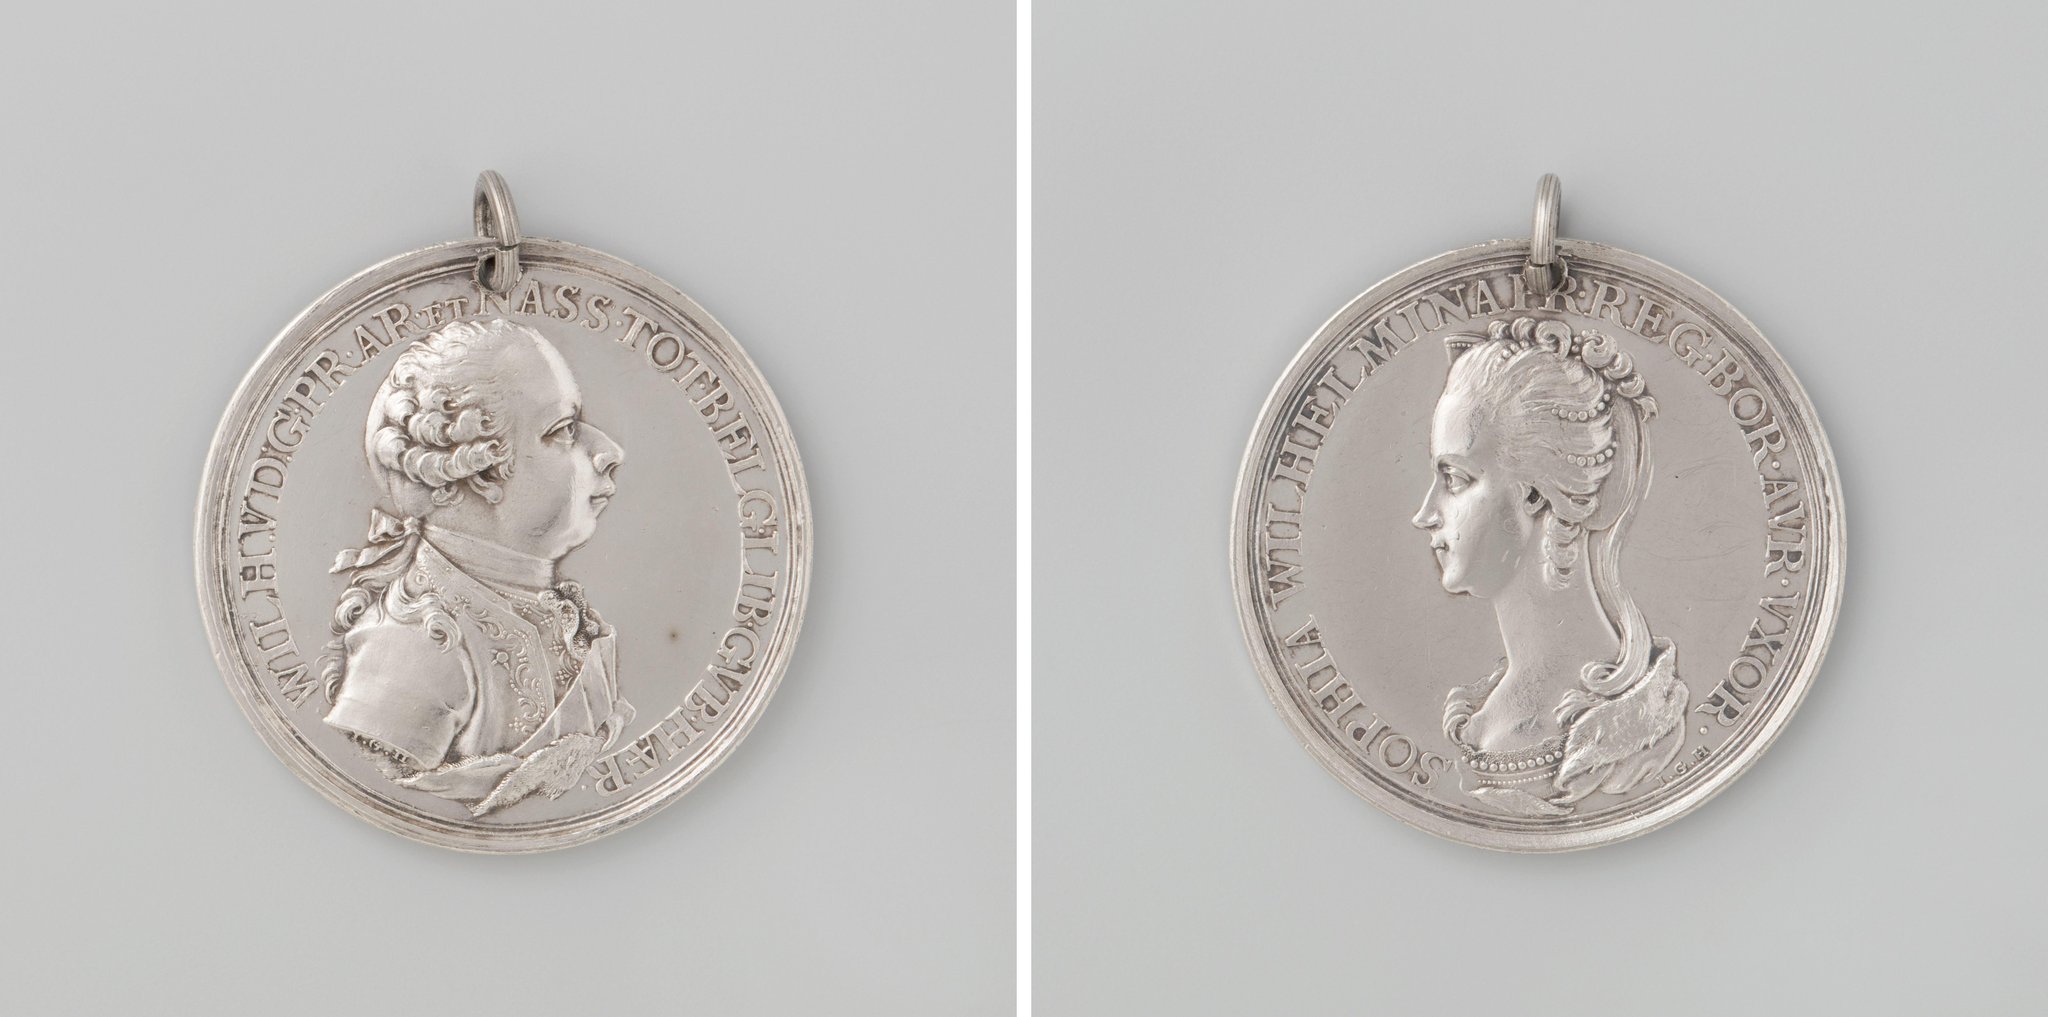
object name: history medal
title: Huwelijk van Willem V met Wilhelmina Frederica Sophia van Pruisen te Berlijn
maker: johan george holtzhey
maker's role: mintmaster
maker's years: 1726-1808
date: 1767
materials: silver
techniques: striking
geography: amsterdam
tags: william v (prince of orange), berlin, painter, draughtsman, wilhelmina of prussia (princess of orange)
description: Zilveren penning met draagring. Voorzijde: borststuk jongeman binnen omschrift. Keerzijde: borststuk vrouw binnen omschrift